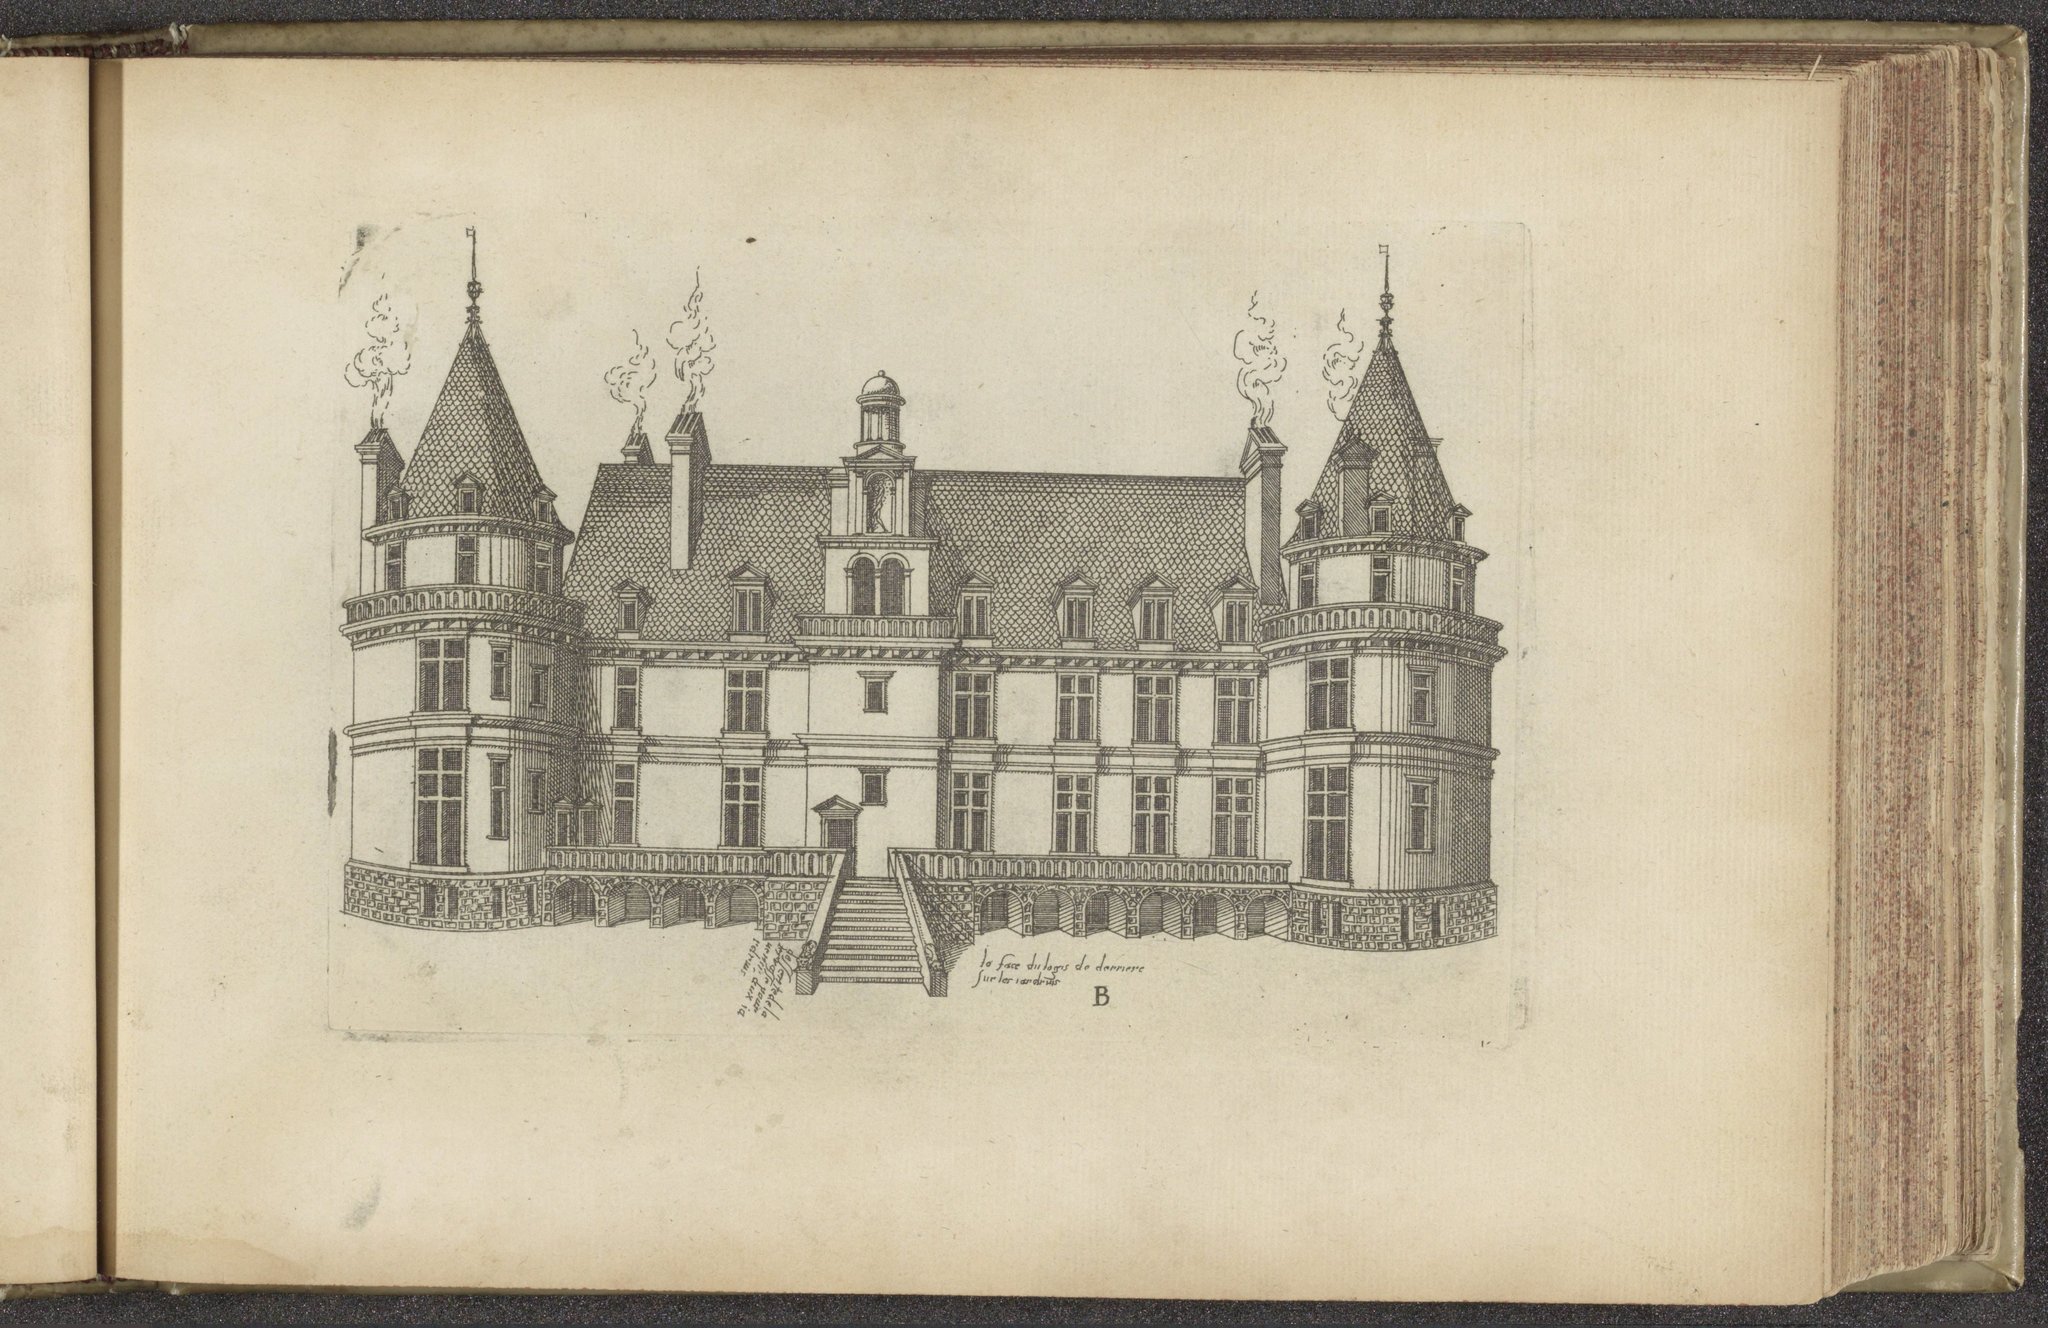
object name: print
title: Vooraanzicht van landhuis B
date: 1540-1545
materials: paper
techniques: etching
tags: castle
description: Deze prent maakt deel uit van een album.